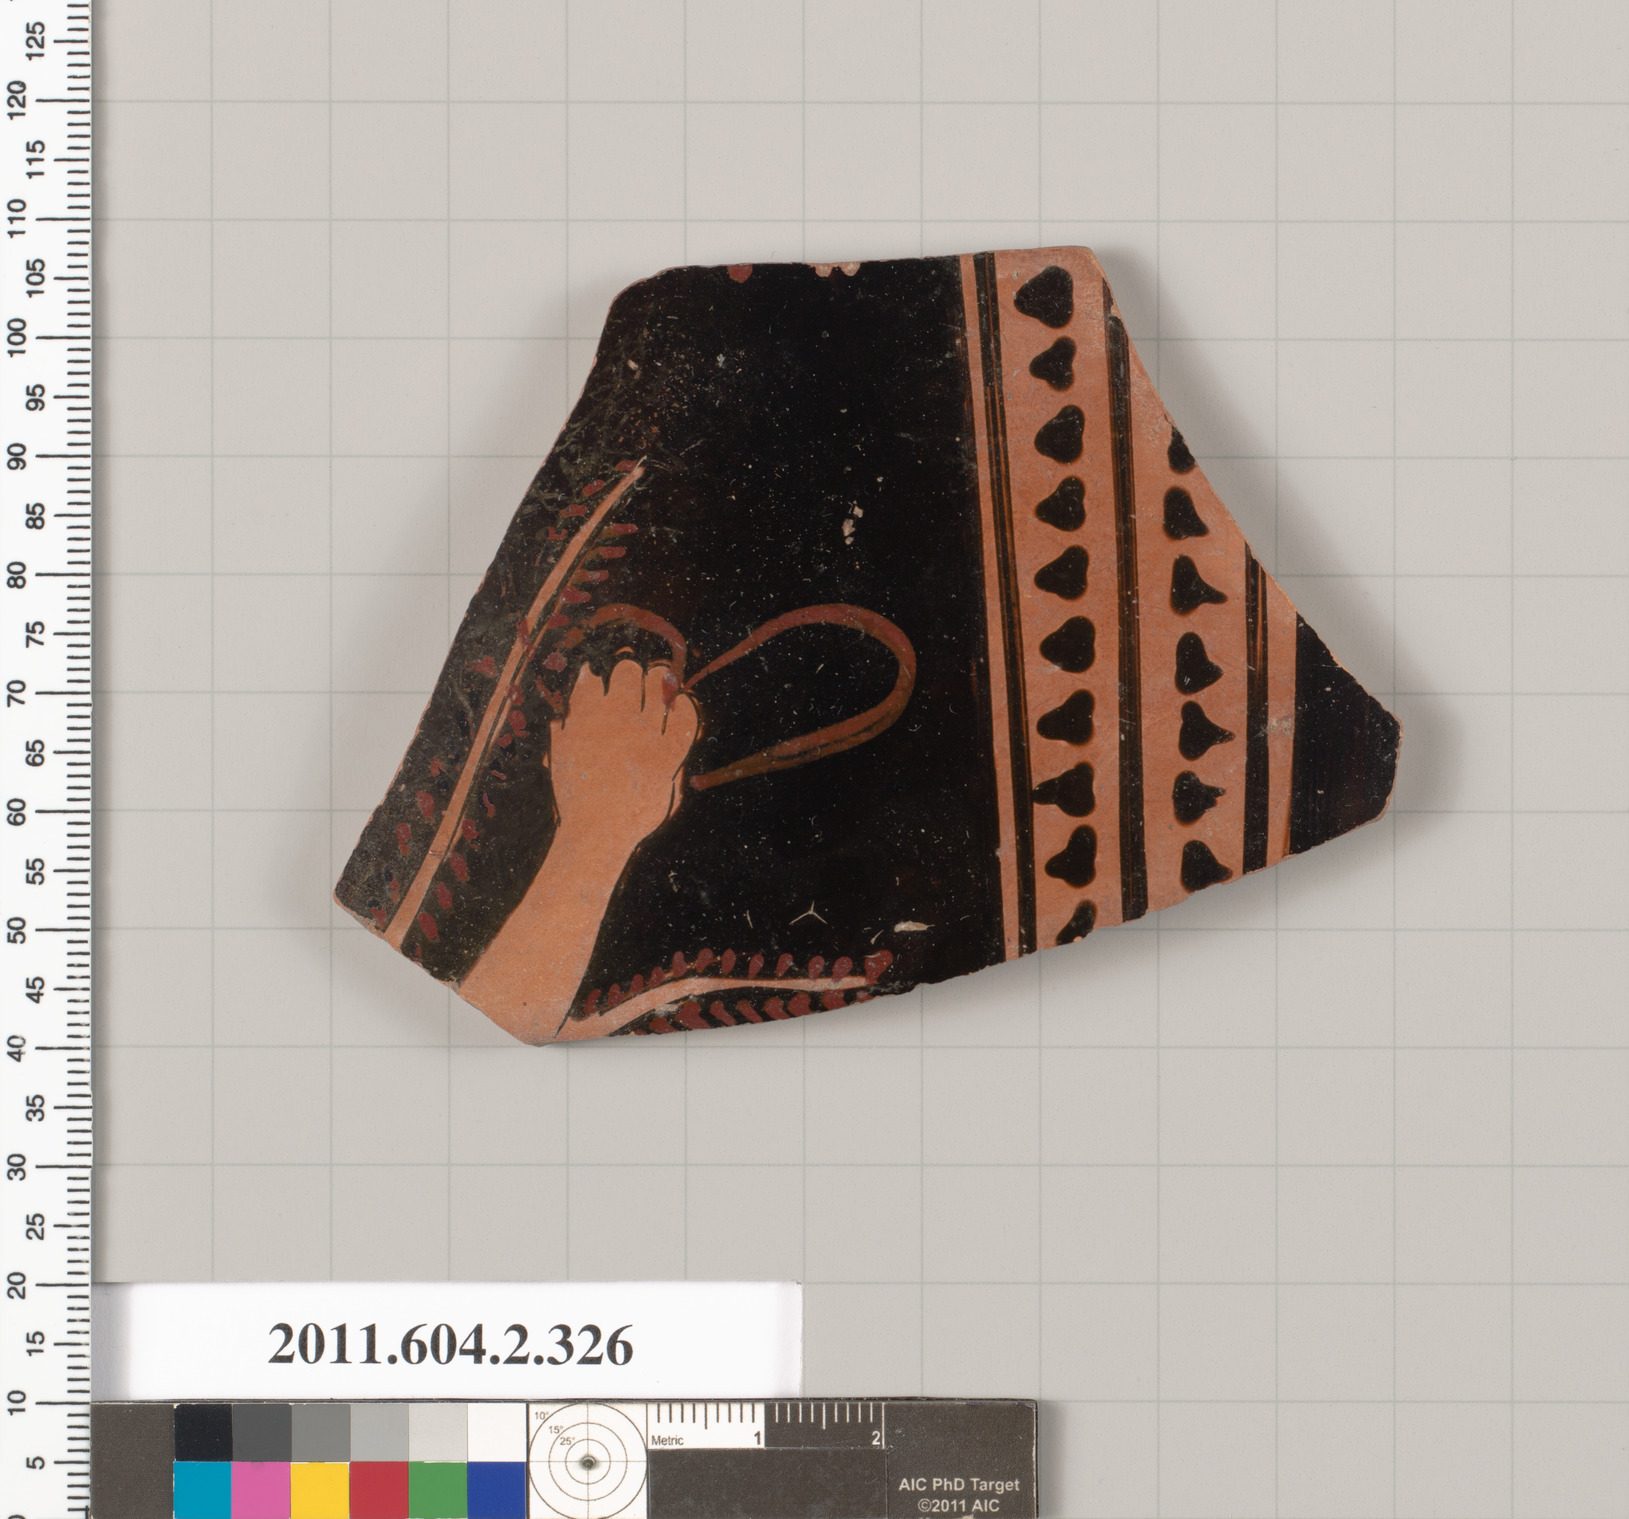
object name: column krater fragment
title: Terracotta fragment of a column-krater (bowl for mixing wine and water)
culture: greek, attic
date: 470-450 BCE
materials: terracotta